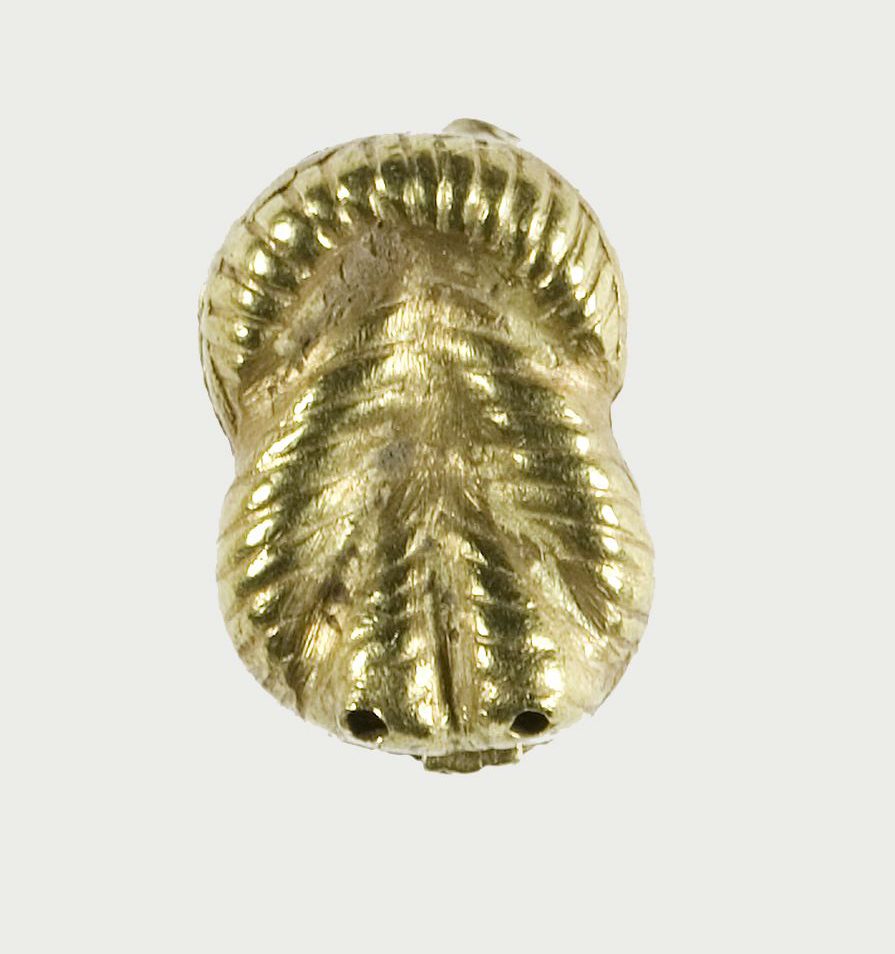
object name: clasp, sithathoryunet, double knot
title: Knot Clasp of Sithathoryunet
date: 1887-1813 BCE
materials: gold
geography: egypt